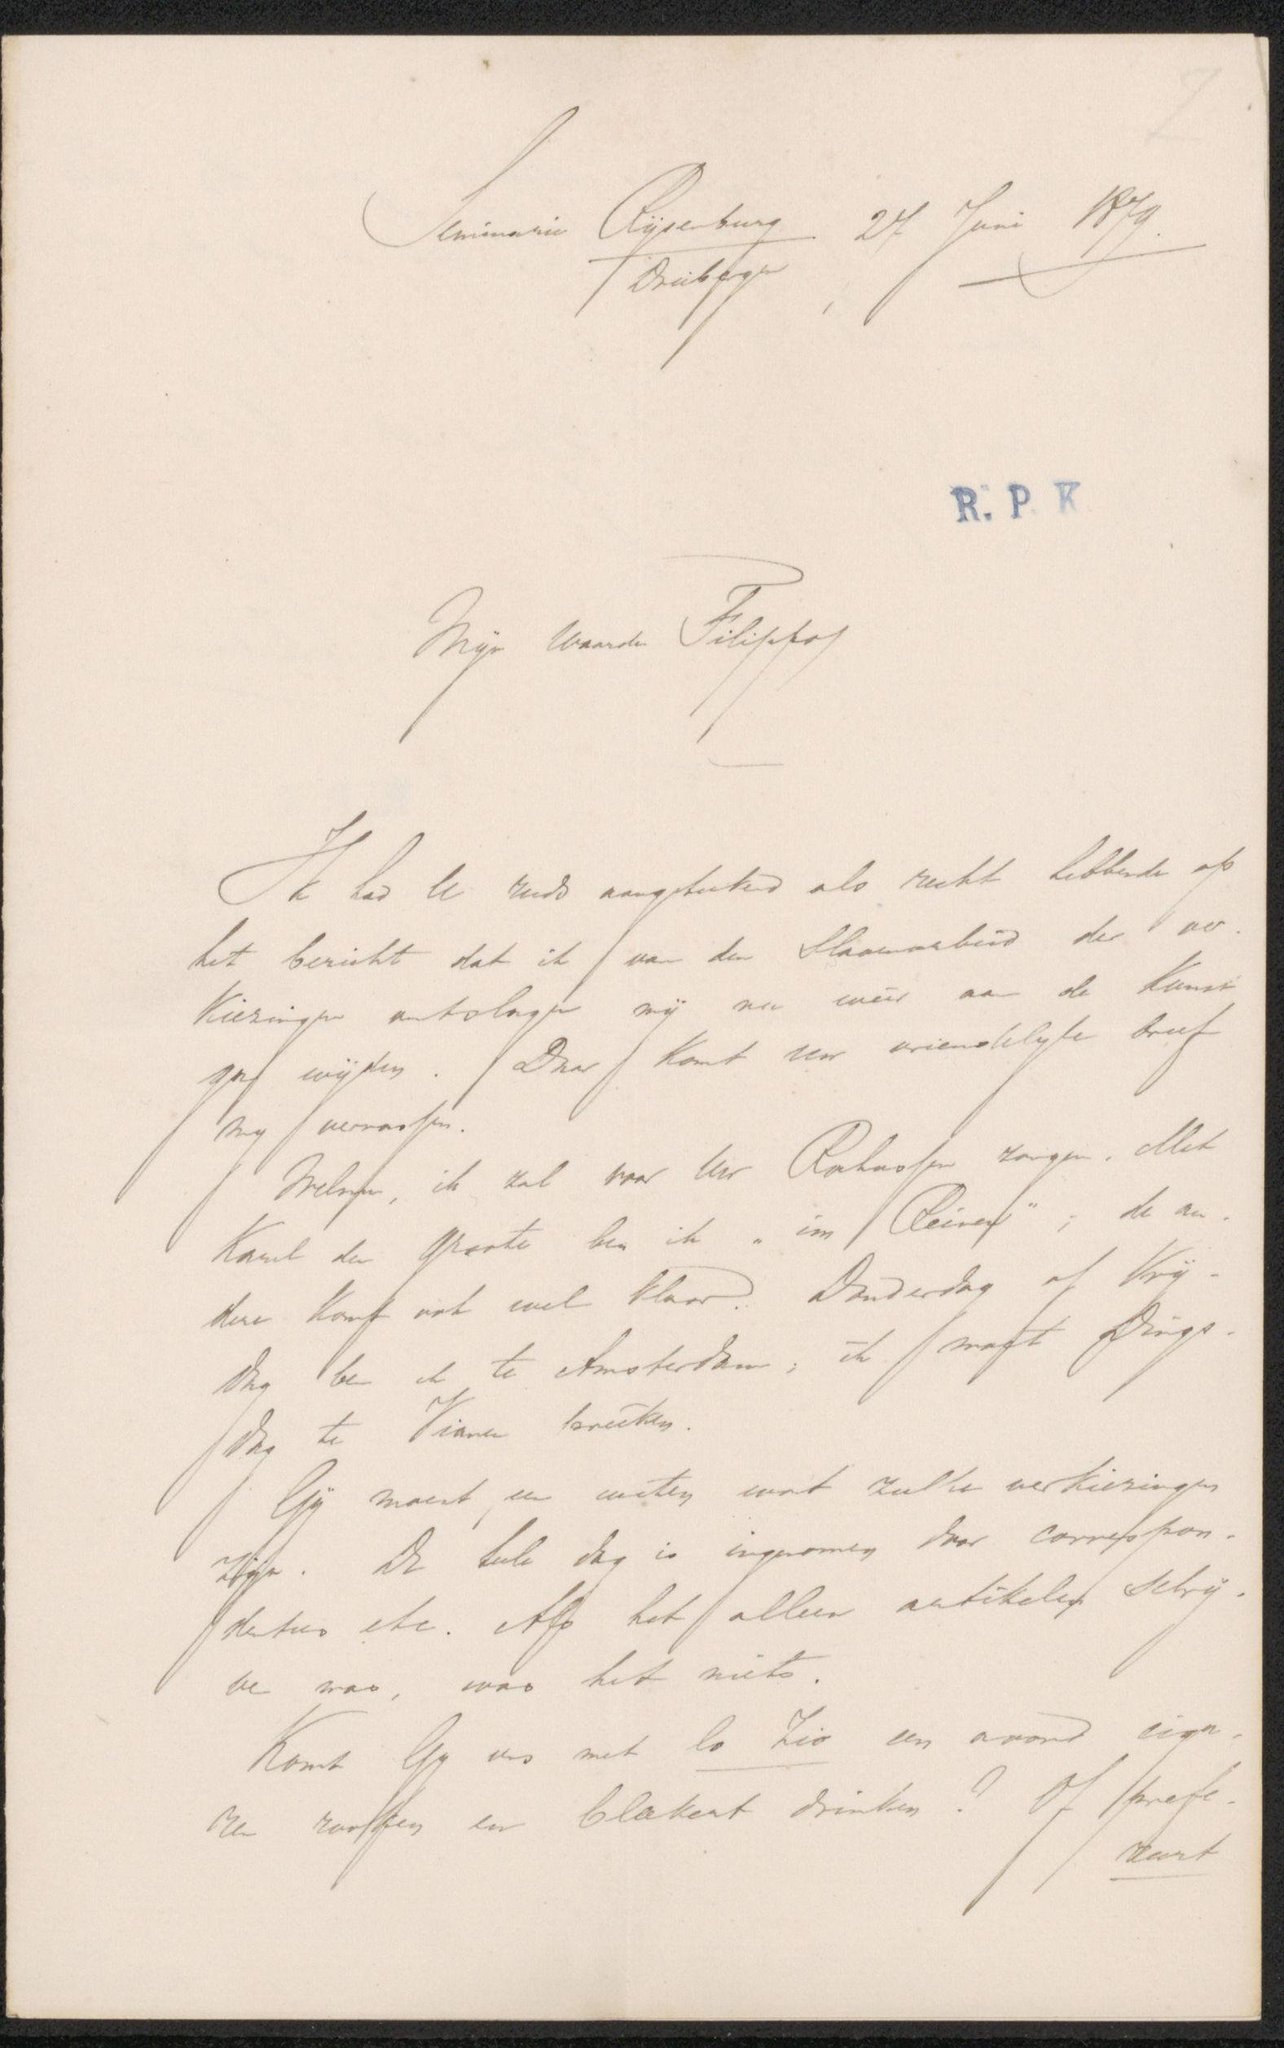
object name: letter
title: Brief aan Filippo Tessaro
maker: herman johannes aloysius maria schaepman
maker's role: priest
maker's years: 1844-1903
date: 1879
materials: ink, paper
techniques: pen, writing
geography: driebergen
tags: amsterdam, rotterdam, print maker, draughtsman, charles rochussen, charlemagne (holy roman emperor), printed matter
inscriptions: collector's mark: Lugt 2233, watermark